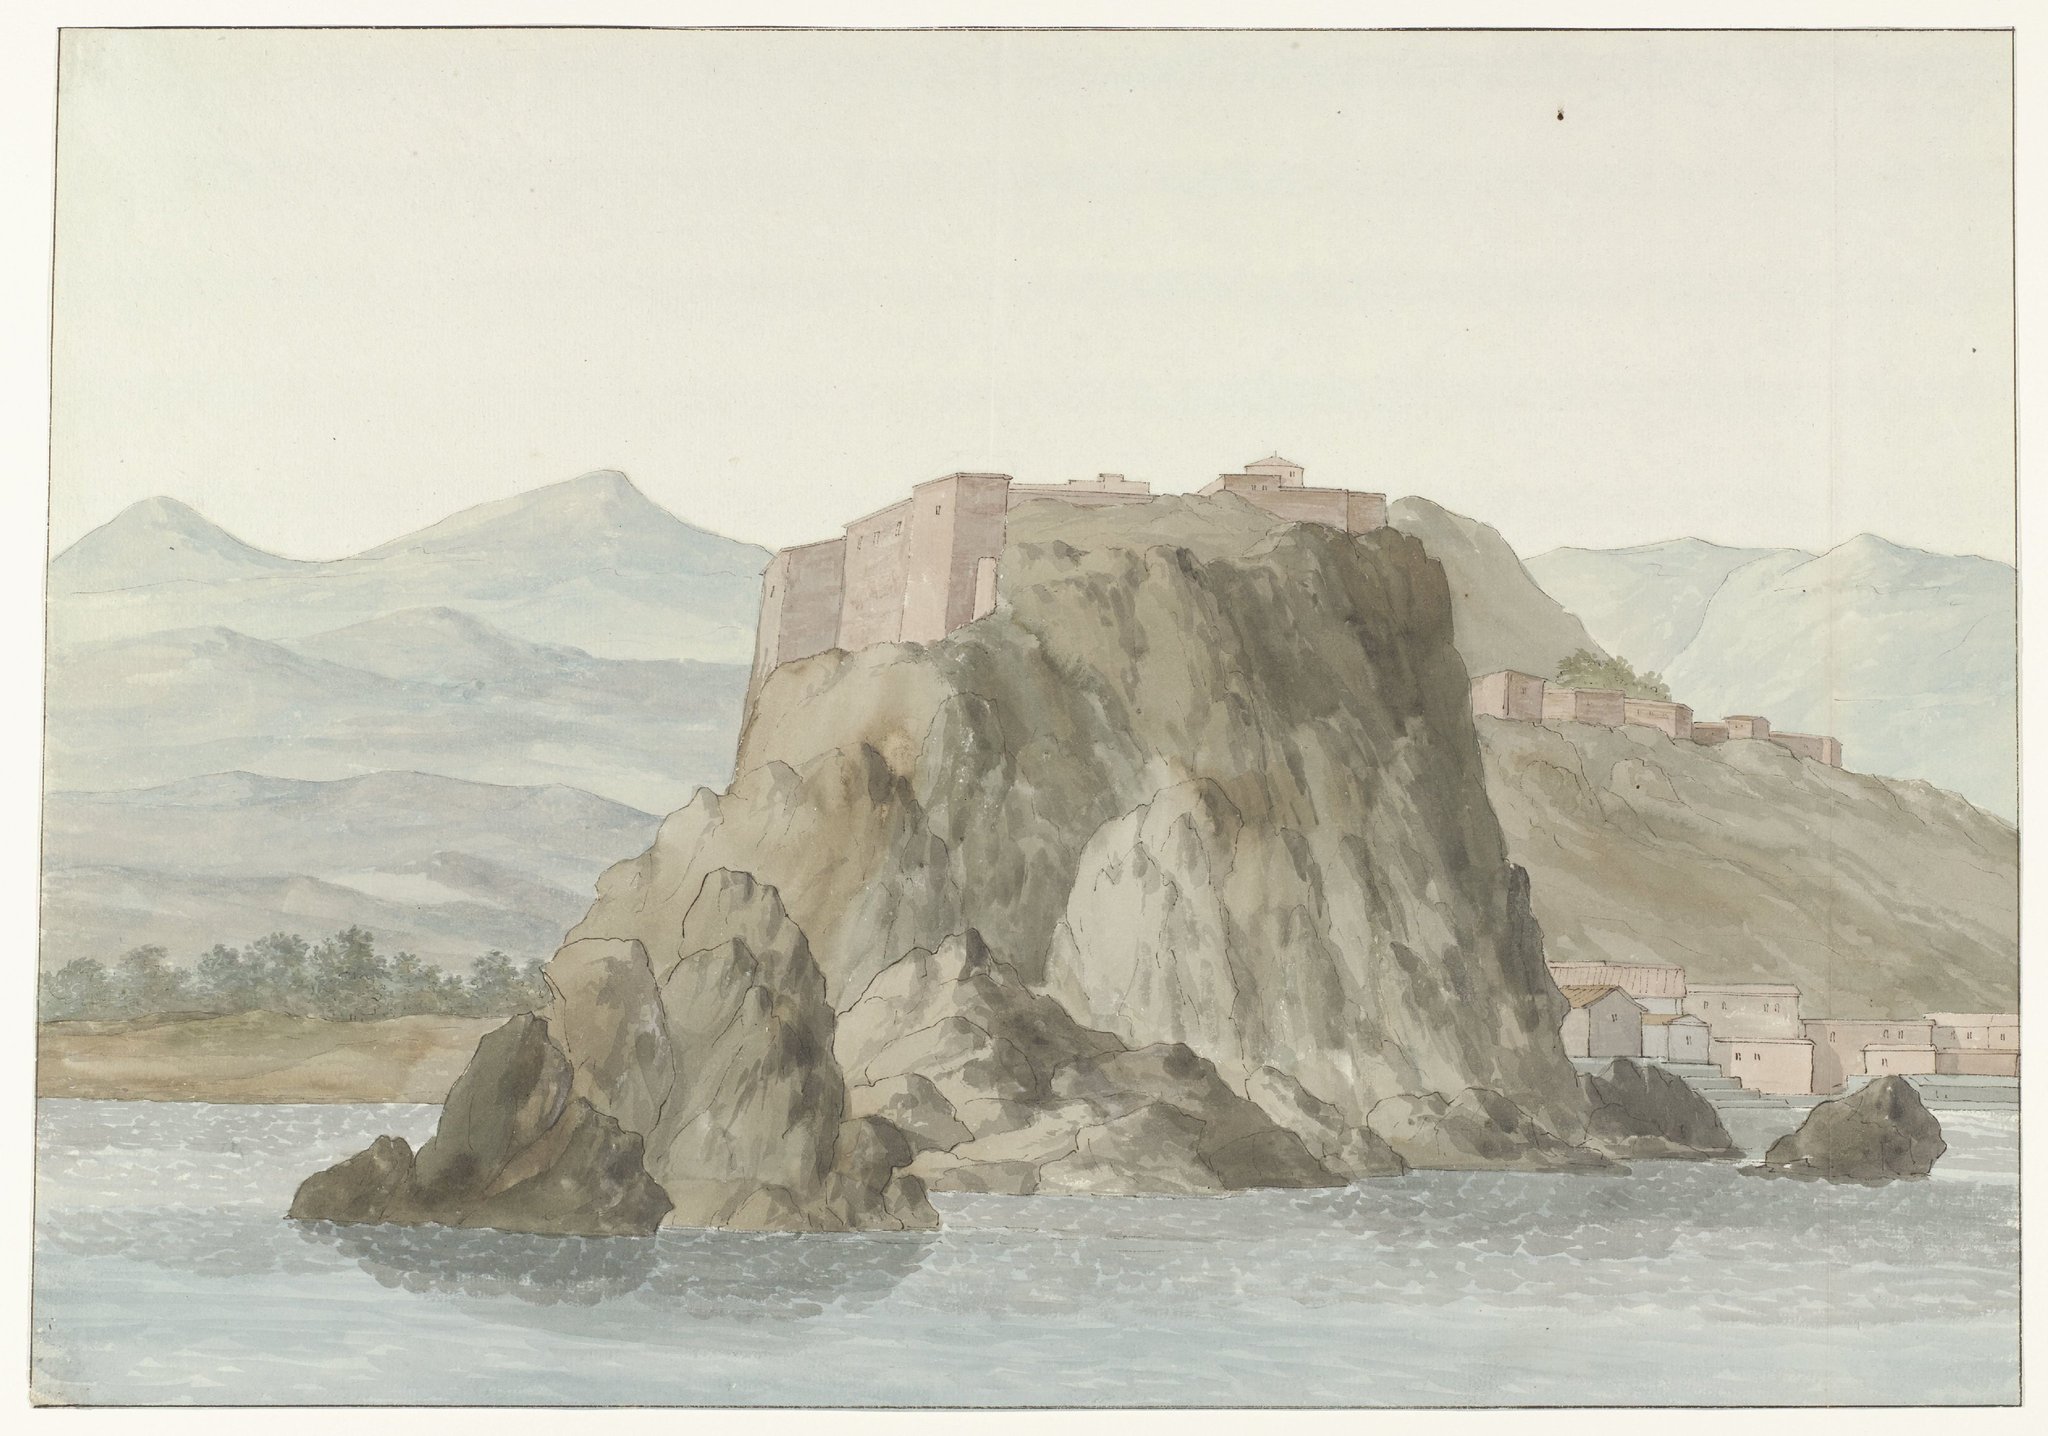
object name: watercolor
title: Rots en stad Scilla in de regio Calabrië gezien vanaf zee aan de noordkant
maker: louis ducros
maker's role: draughtsman, print maker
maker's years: 1748-1810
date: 1778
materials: chalk, paper, watercolor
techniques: brush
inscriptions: inscription: ‘No 175 Rocher & Ville de Scilla en Calabre; vue prise en mer, du côté du Nord’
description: Tekening uit het album 'Voyage en Italie, en Sicile et à Malte', 1778.